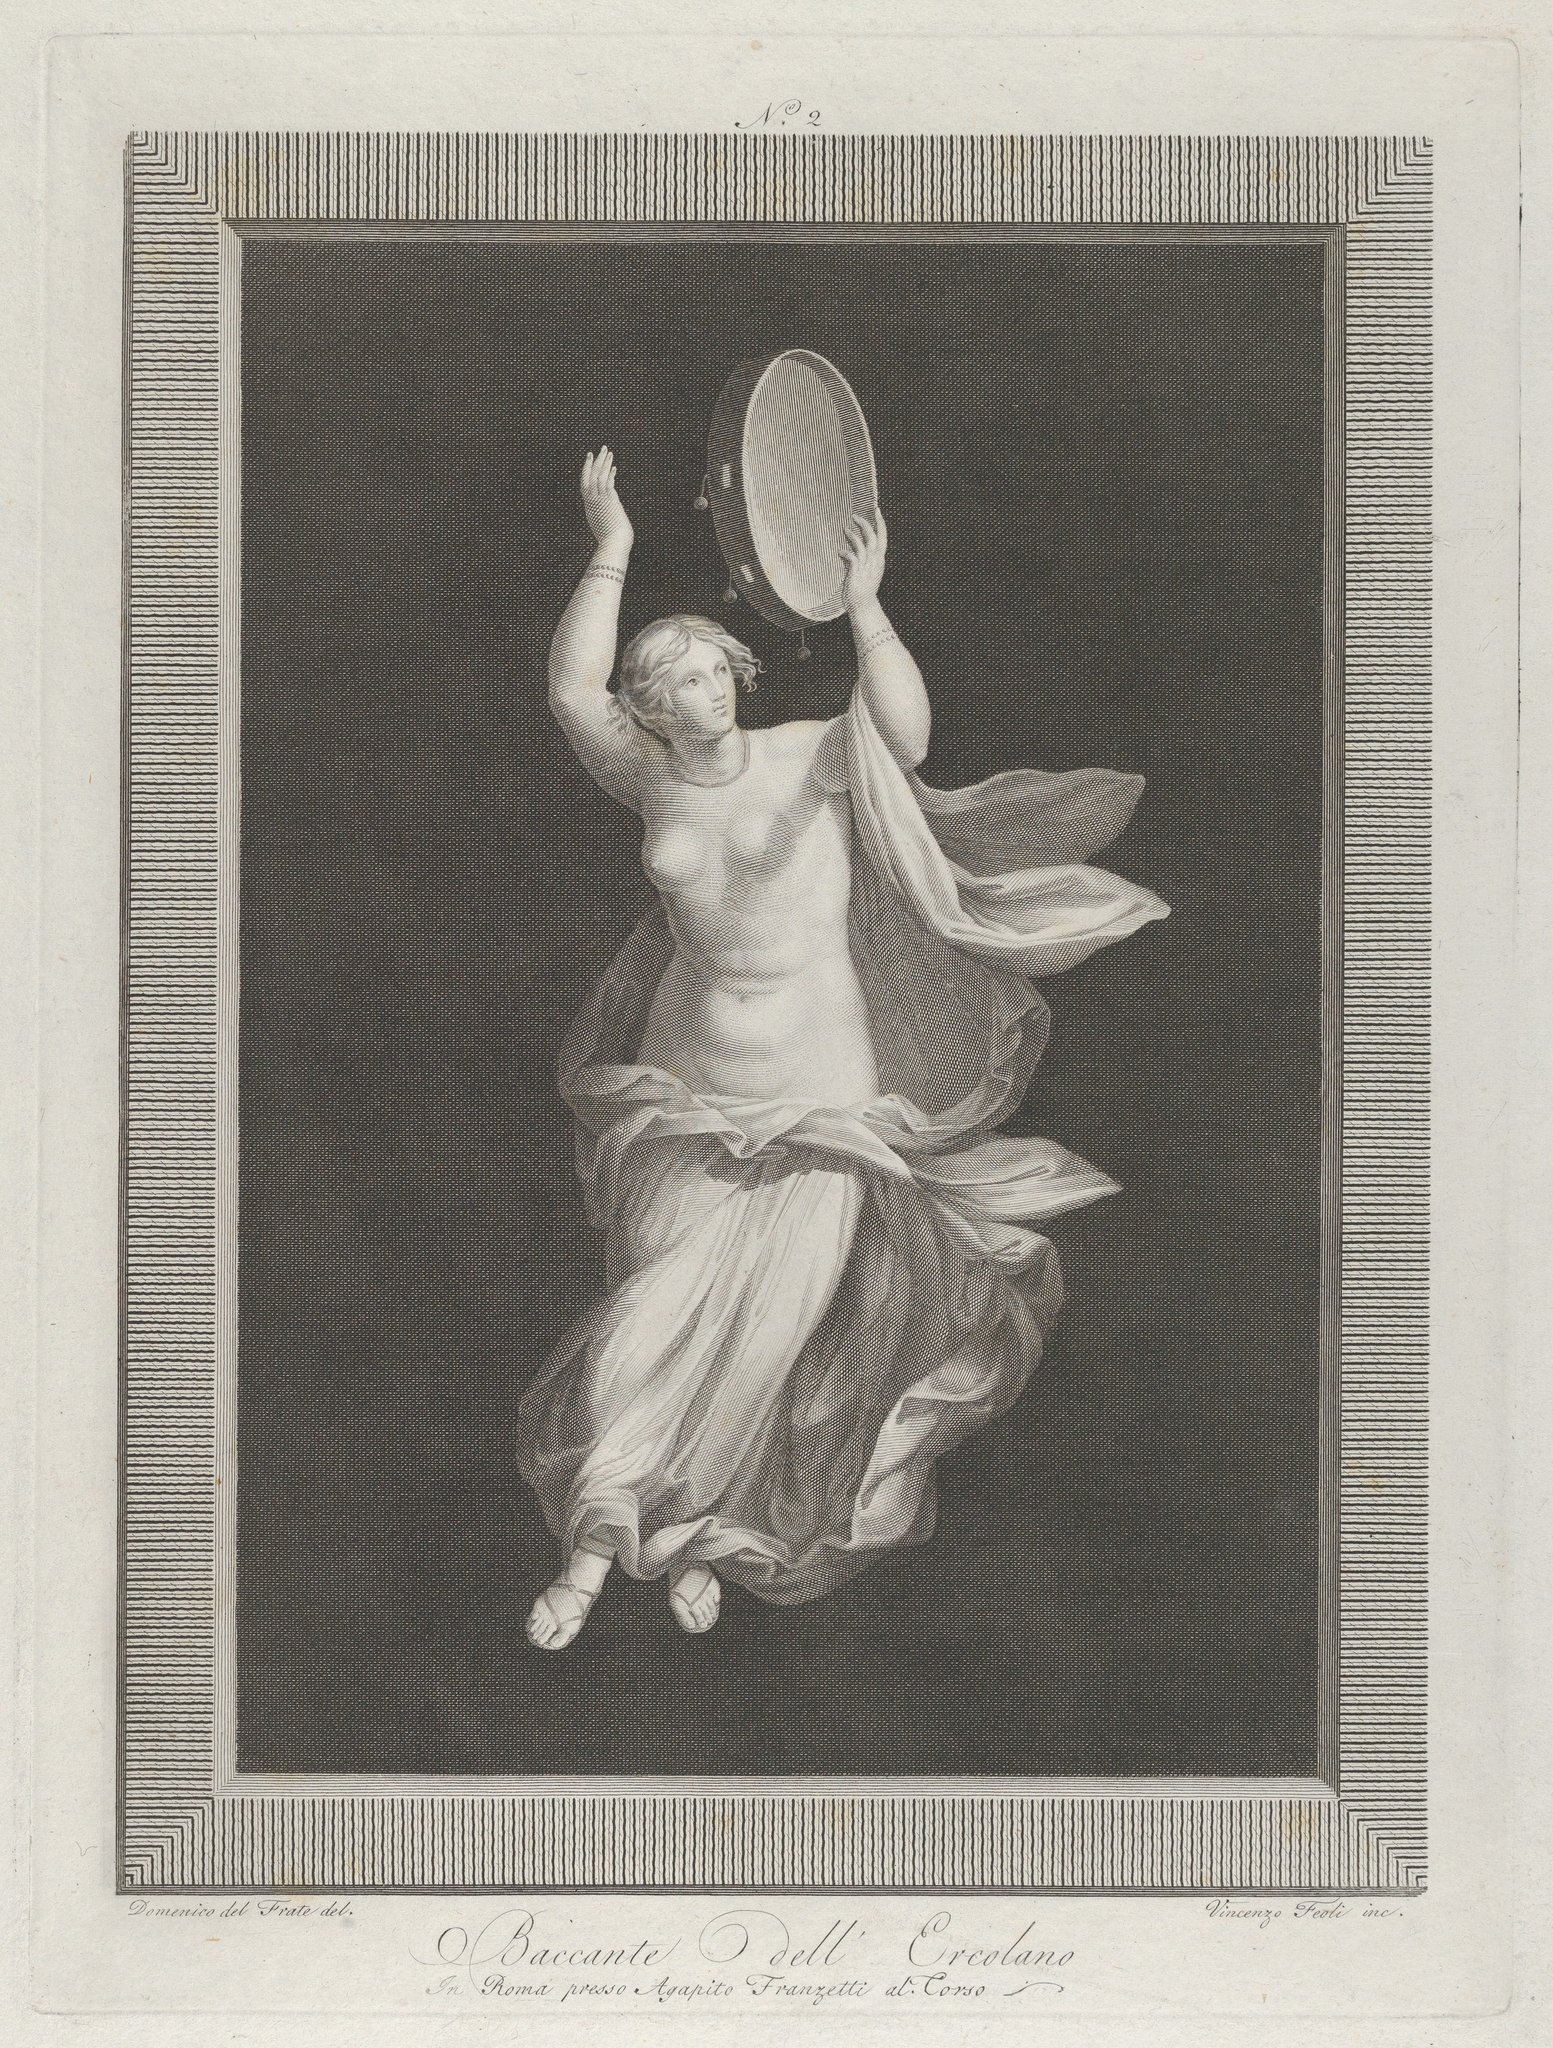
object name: print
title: A partly naked bacchante playing a tambourine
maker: vicenzo feoli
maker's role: artist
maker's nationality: italian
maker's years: 1755-1827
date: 1795-1820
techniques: engraving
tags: bacchantes